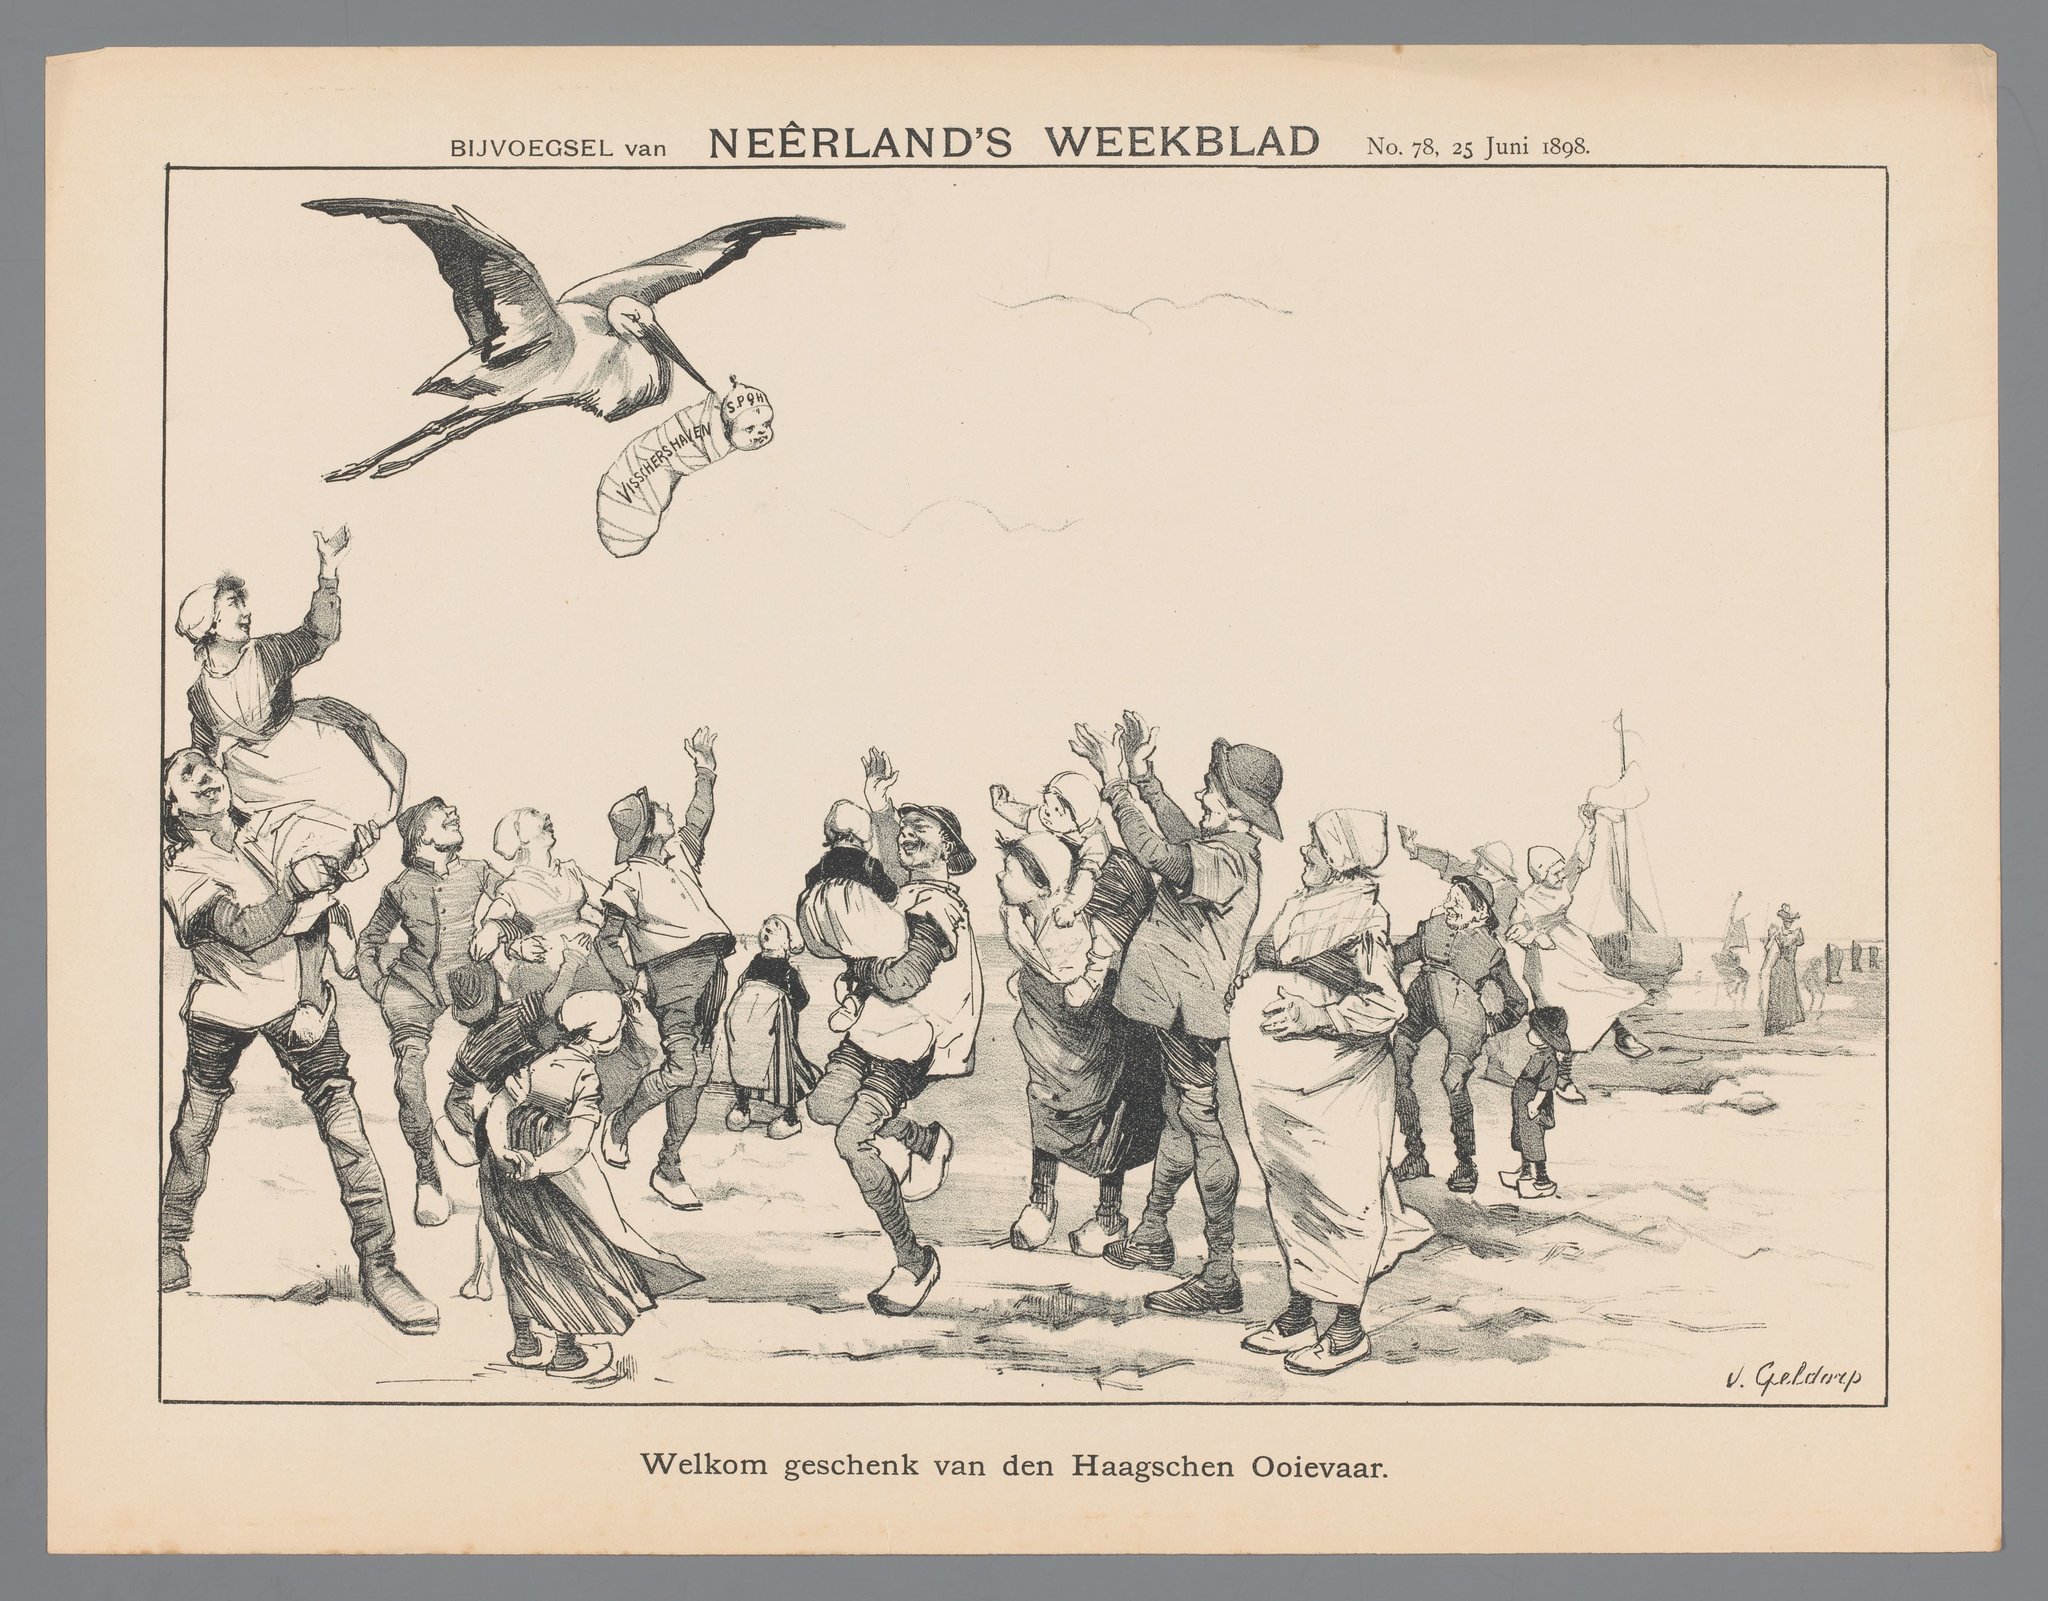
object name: cartoon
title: Welkom geschenk van den Haagschen Ooievaar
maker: petrus van geldorp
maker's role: draughtsman, print maker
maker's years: 1872-1939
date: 1898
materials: paper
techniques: lithograph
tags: shore-birds and wading-birds: stork, political caricatures and satires, the hague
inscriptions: date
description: Prent uit het bijvoegsel van: Neêrland’s Weekblad, nr. 78, 25 juni 1898.